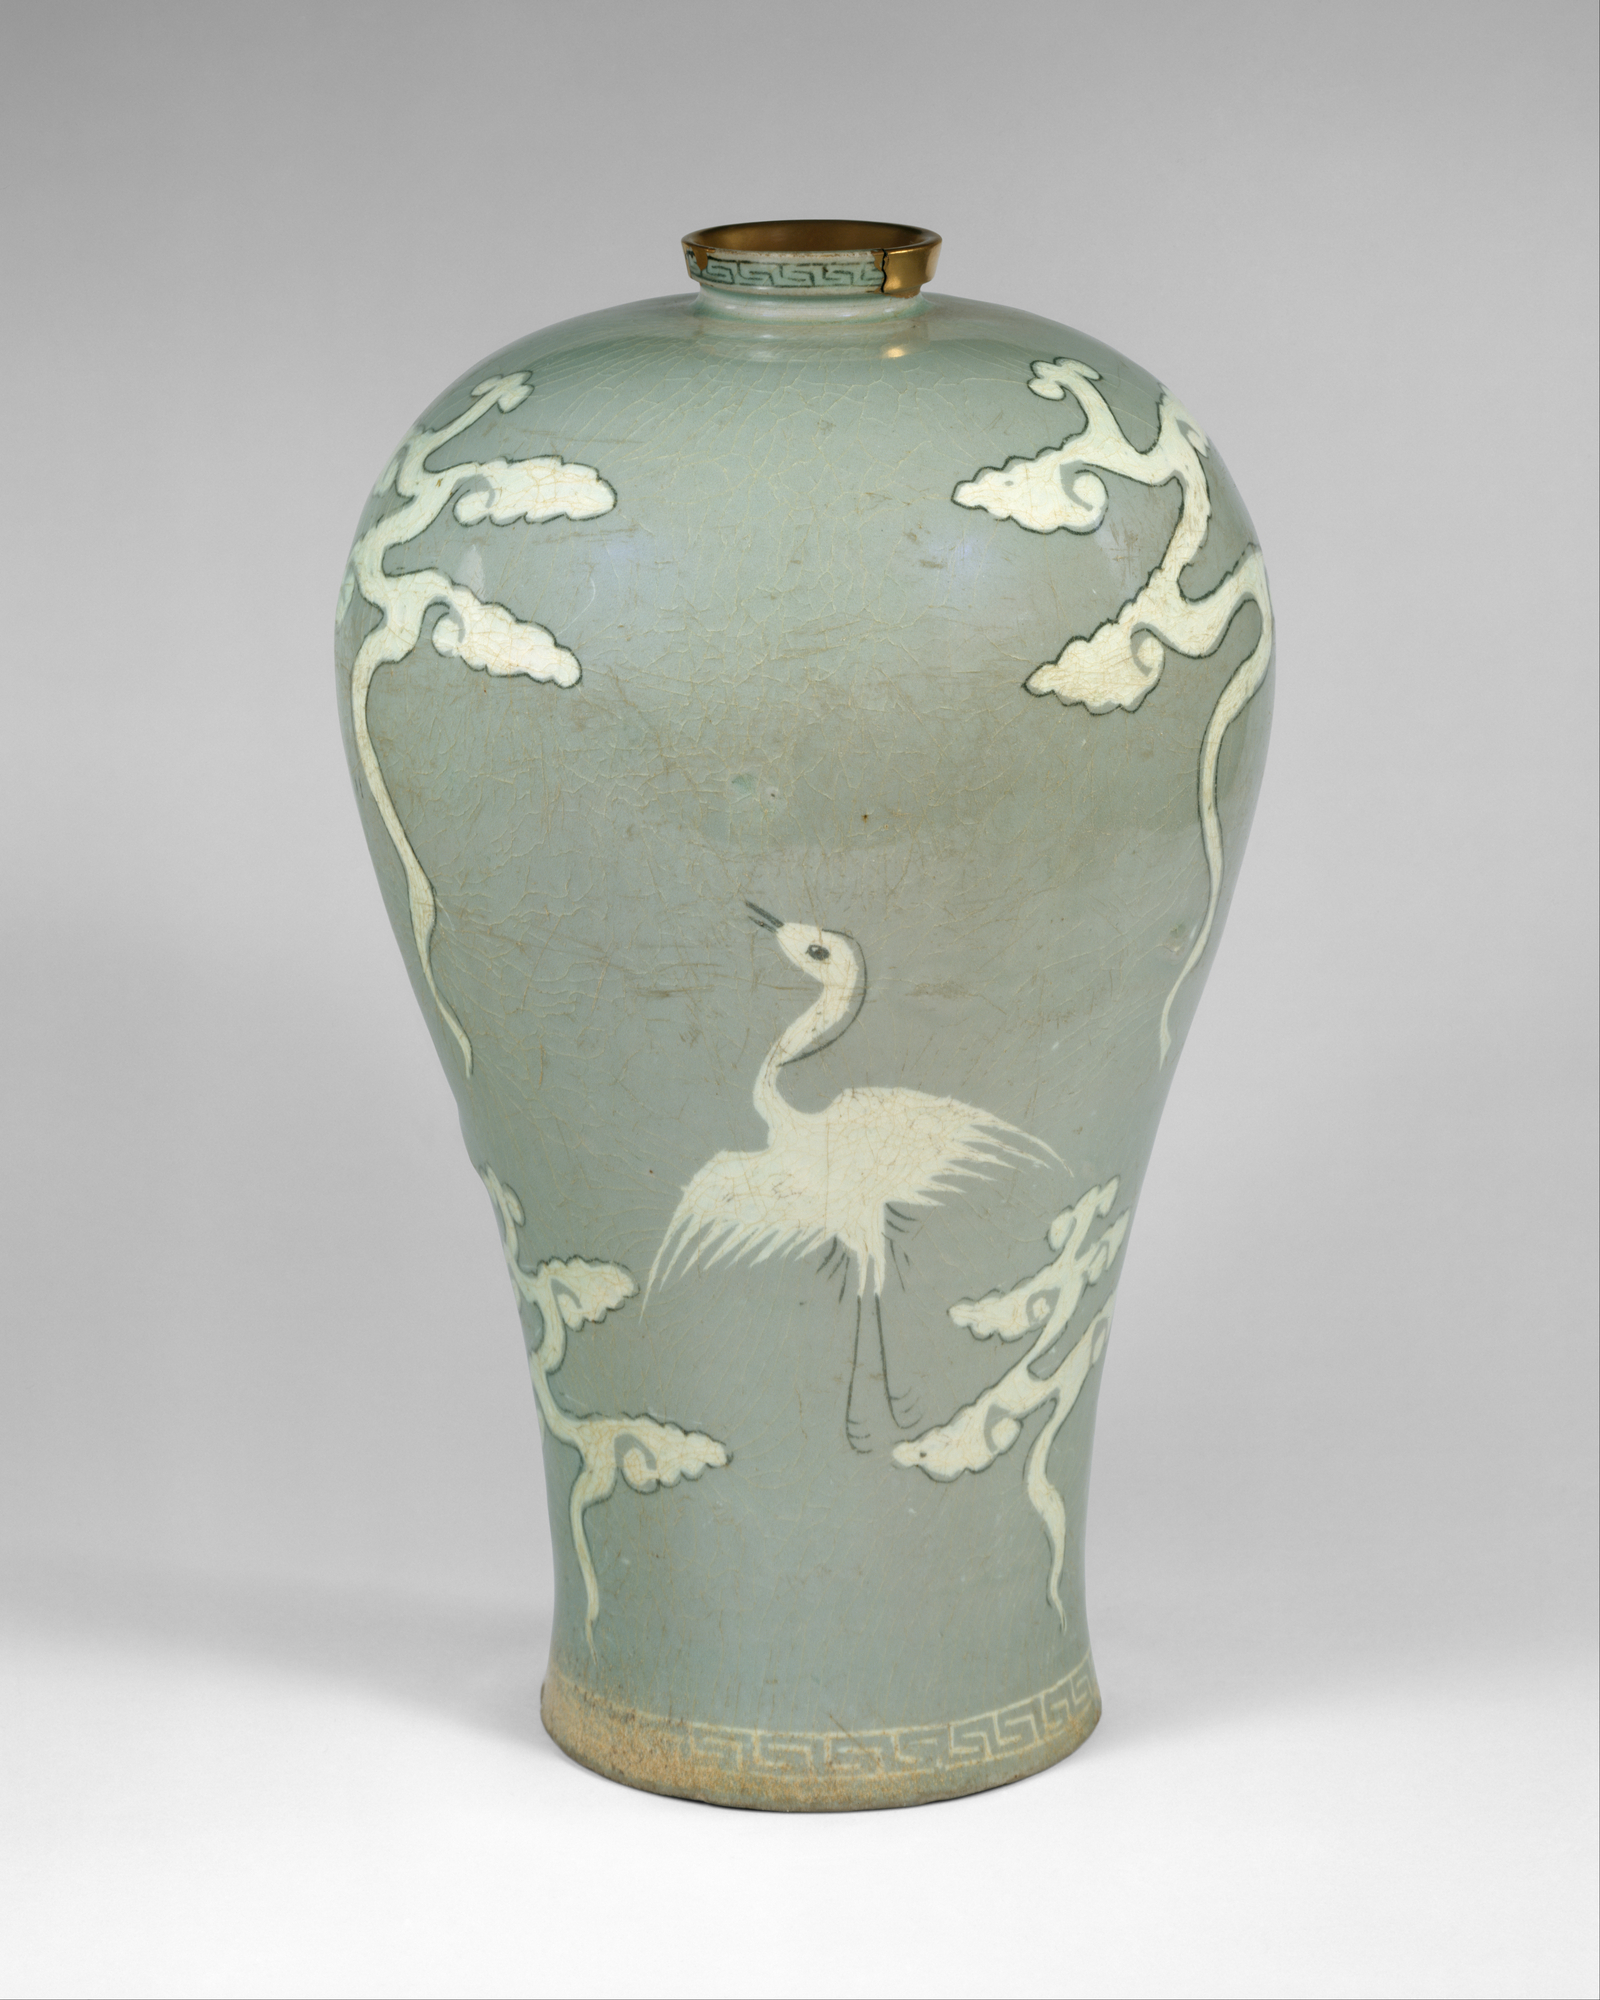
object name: vase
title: Maebyeong (plum bottle) decorated with cranes and clouds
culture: korean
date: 1267-1300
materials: ceramic glaze, glaze, stoneware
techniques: inlay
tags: cranes,clouds